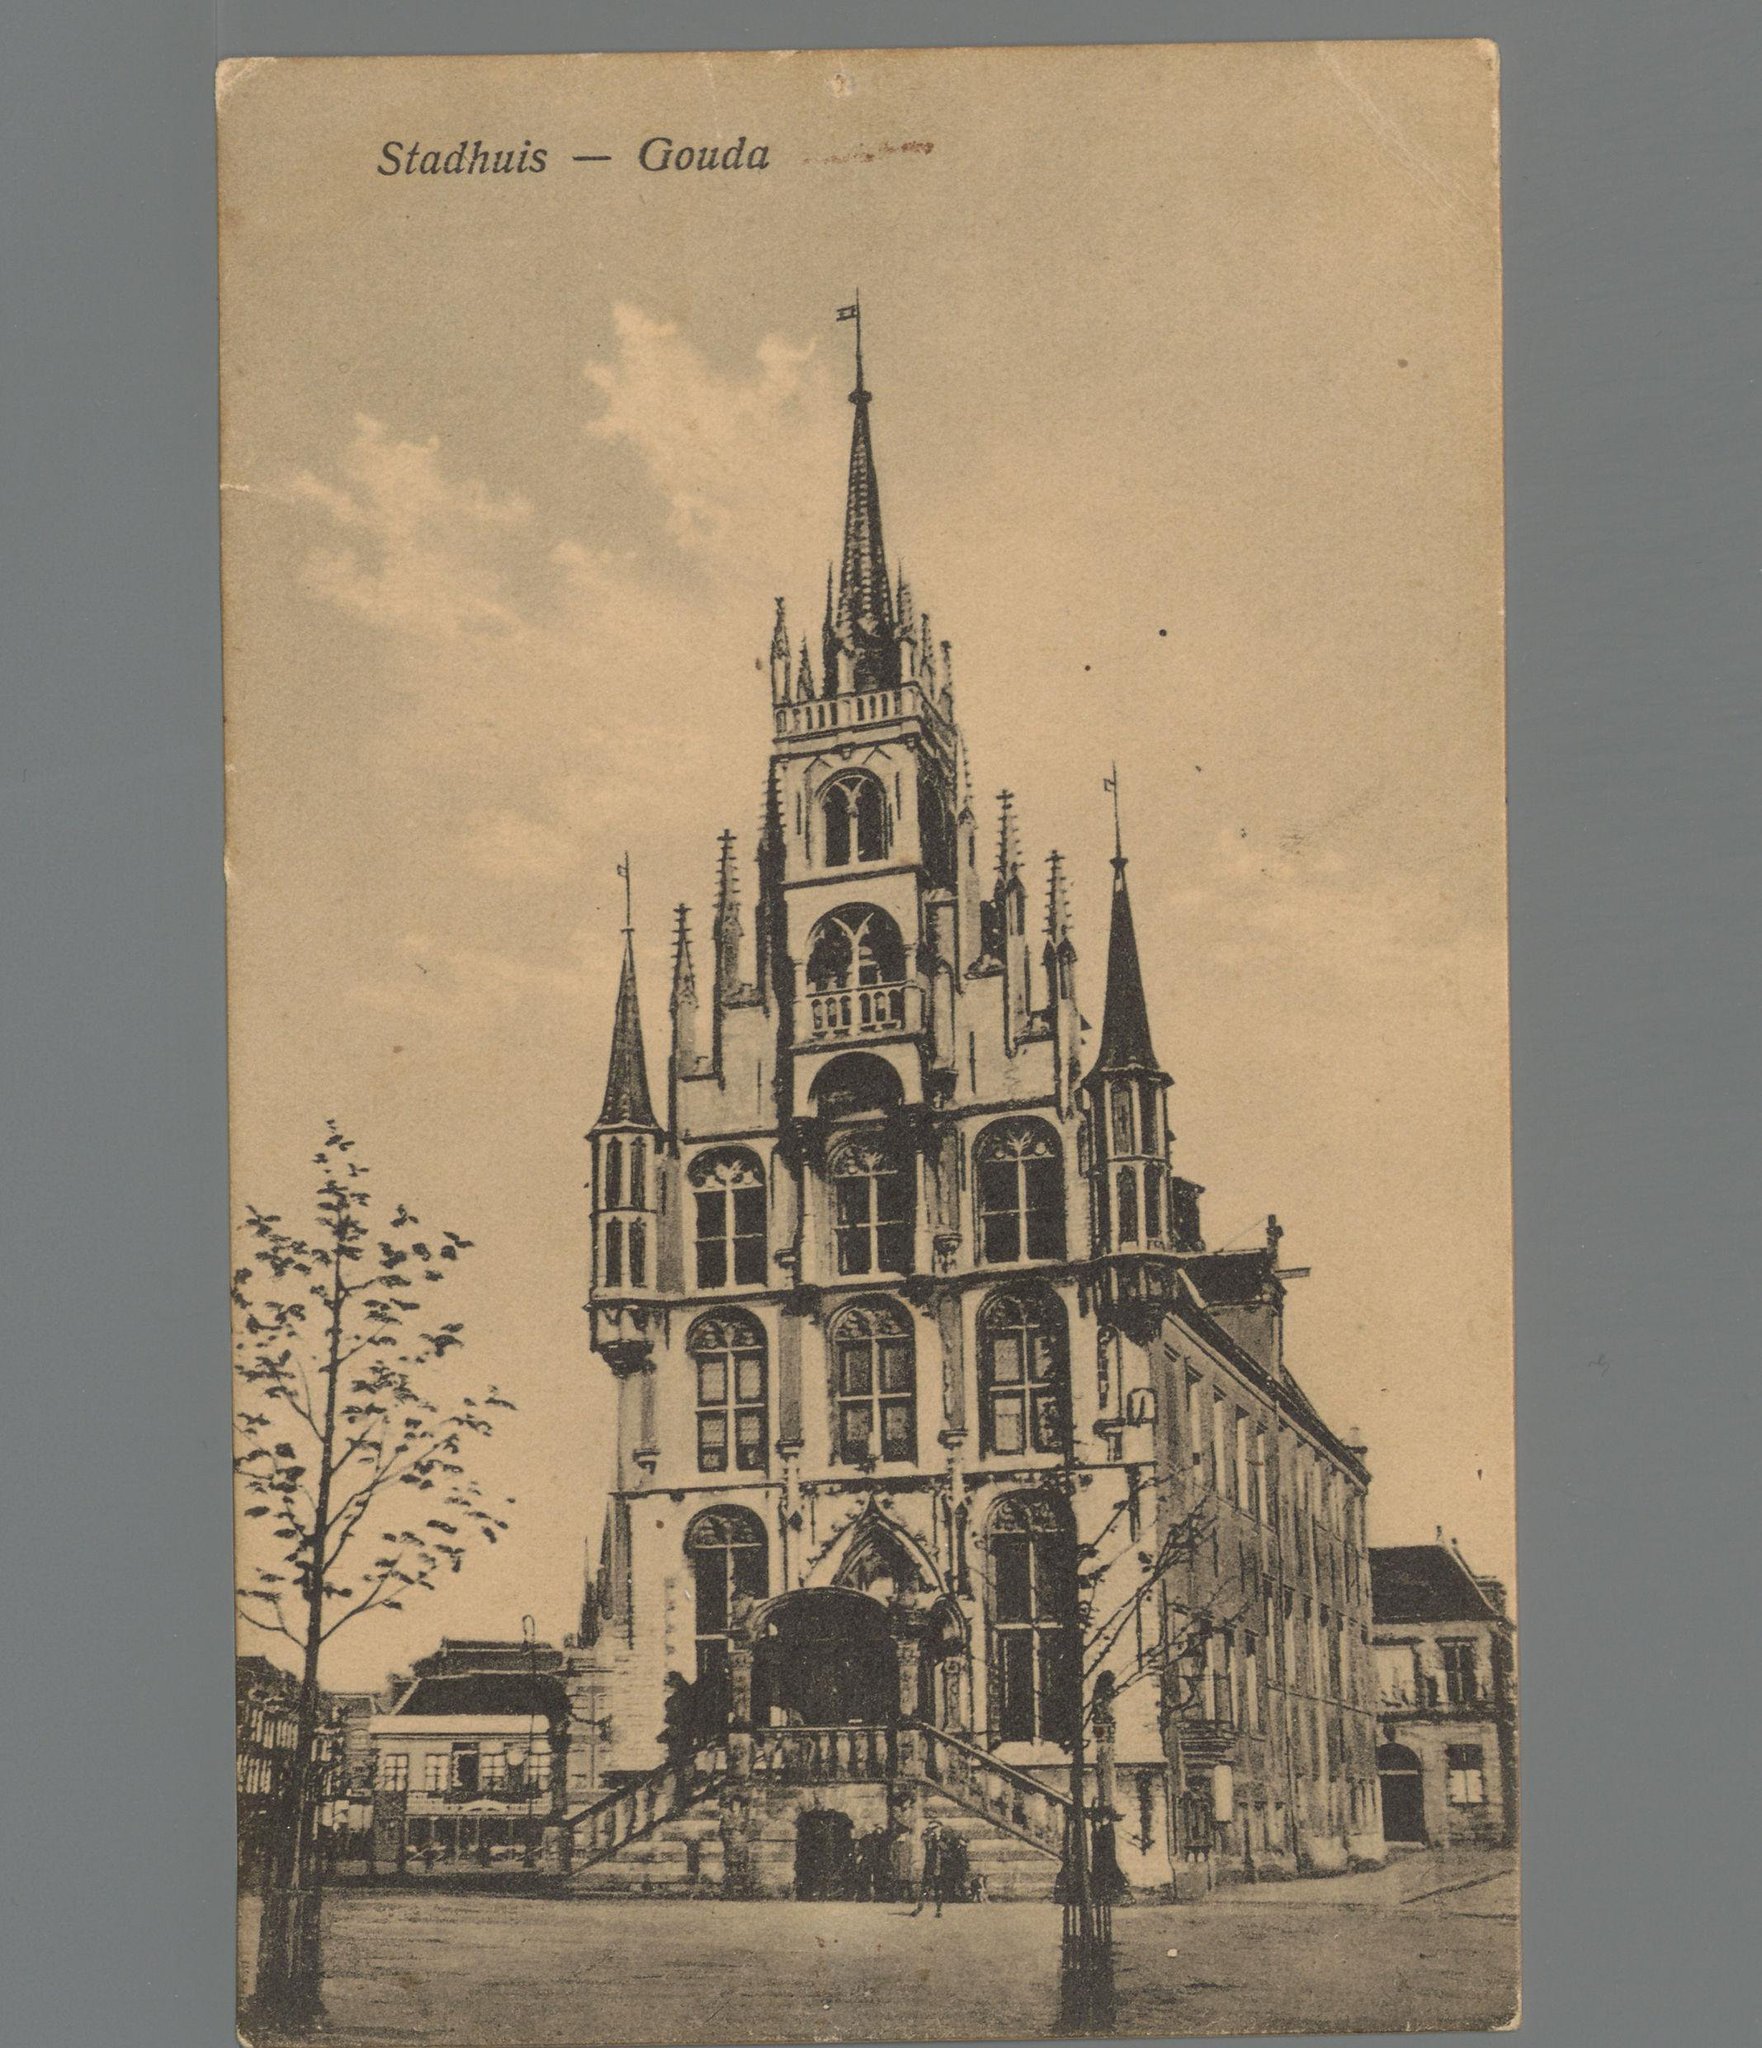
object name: ansichtkaart, prentbriefkaart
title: Stadhuis - Gouda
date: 1905-1928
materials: cardboard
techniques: photograph, writing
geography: gouda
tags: square, place, circus, etc., townhall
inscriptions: postage stamp